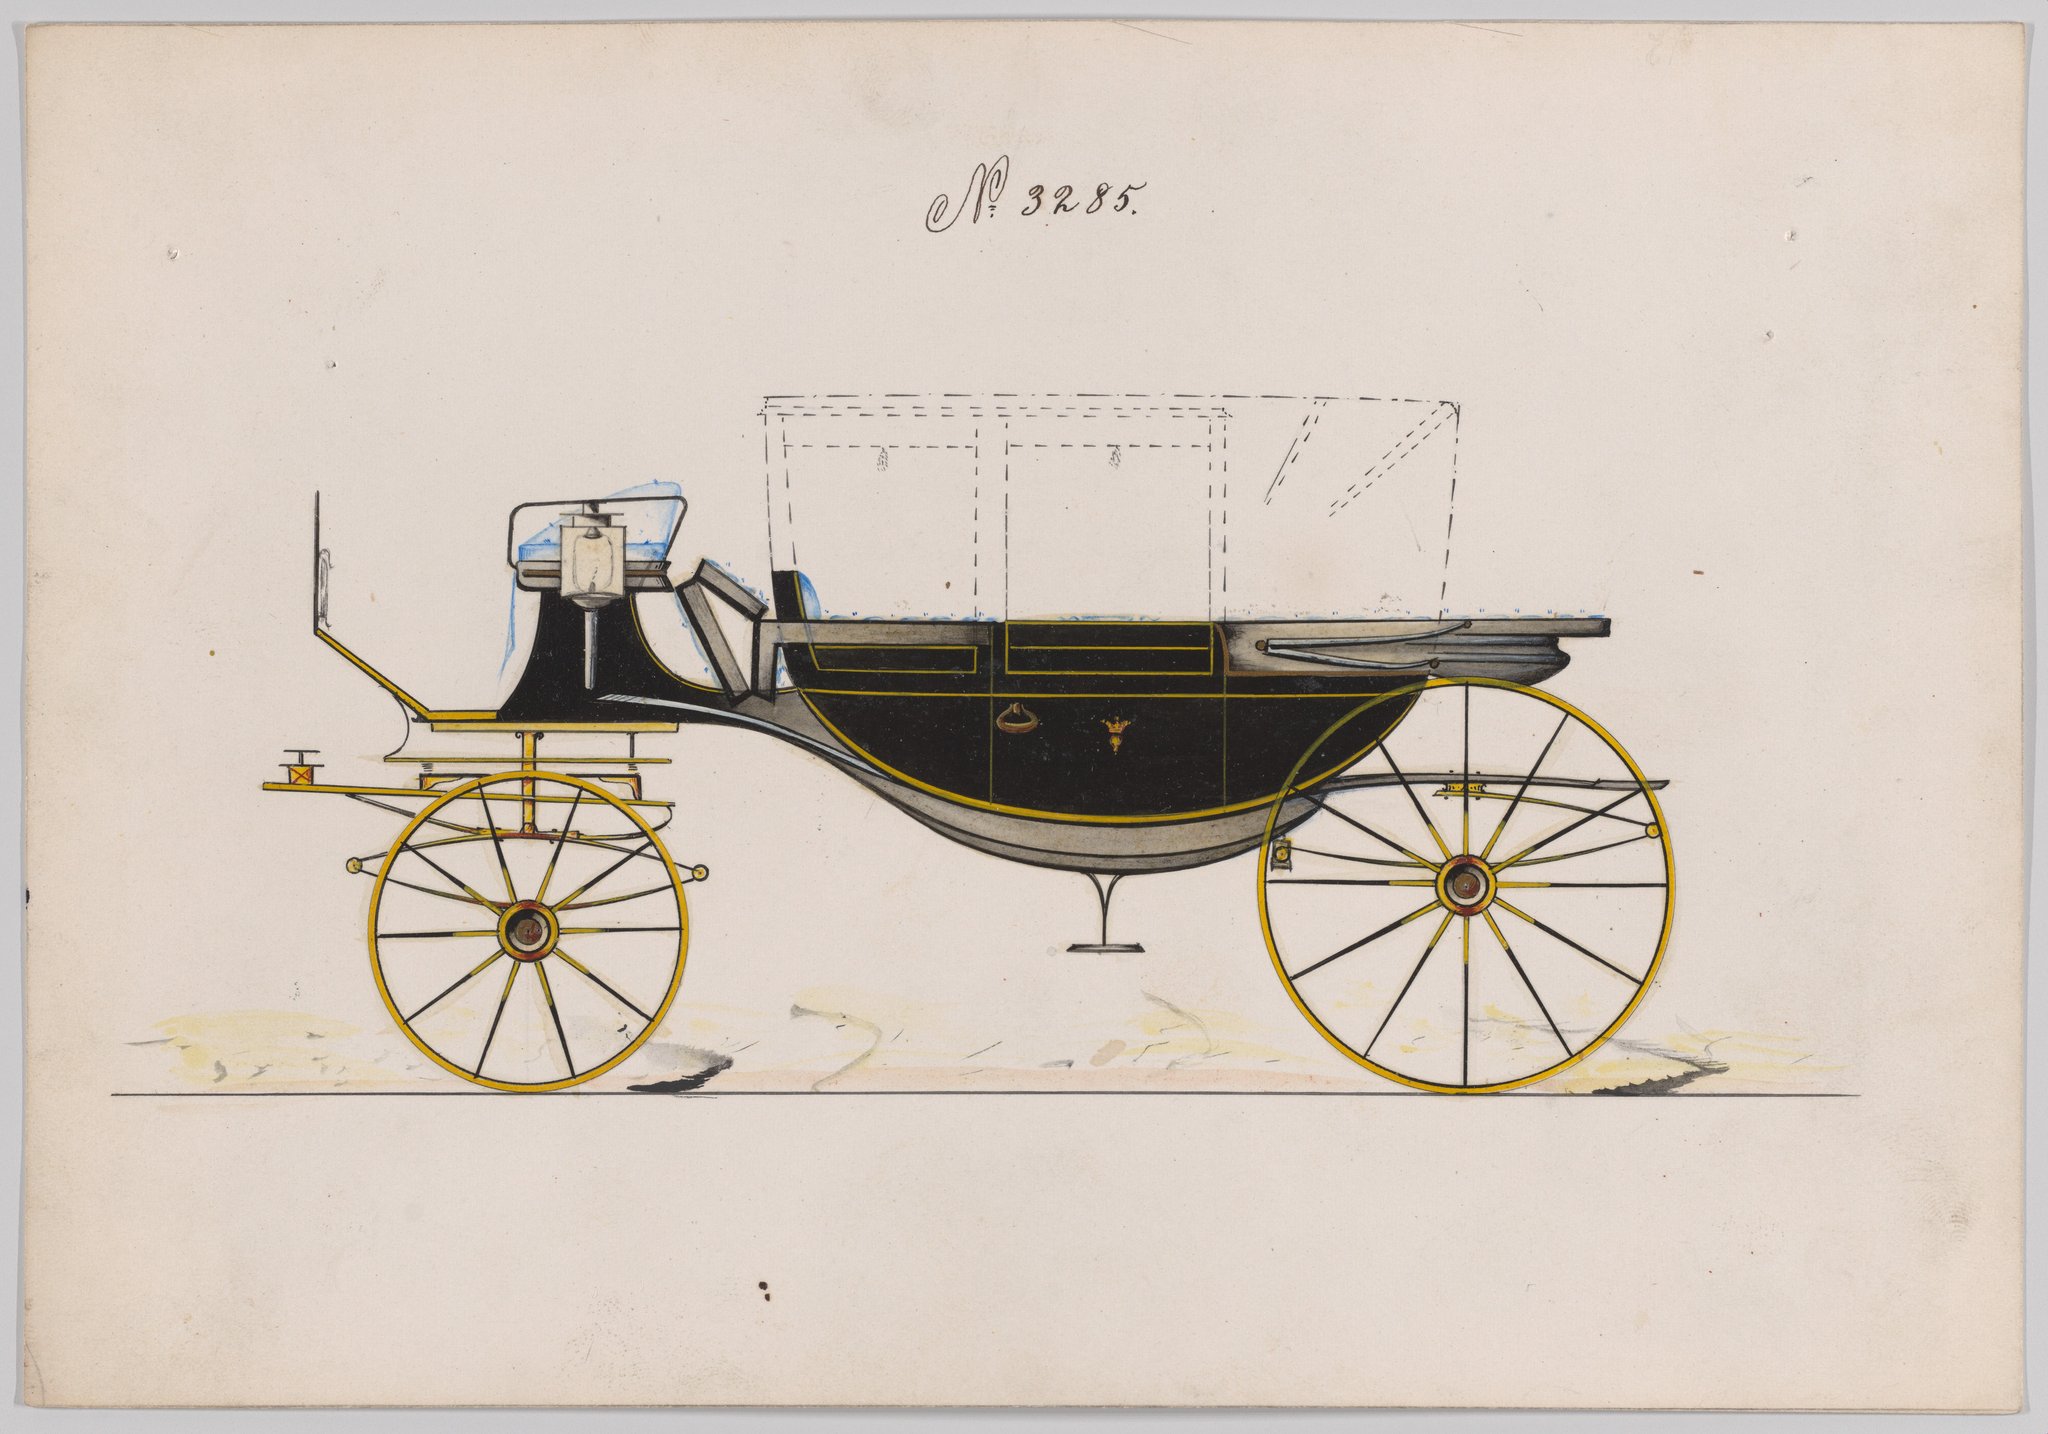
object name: drawing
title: Design for Landau, No. 3285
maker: brewster & co.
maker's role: manufacturer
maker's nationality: american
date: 1876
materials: gouache, gum arabic, ink, watercolor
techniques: pen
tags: carriages